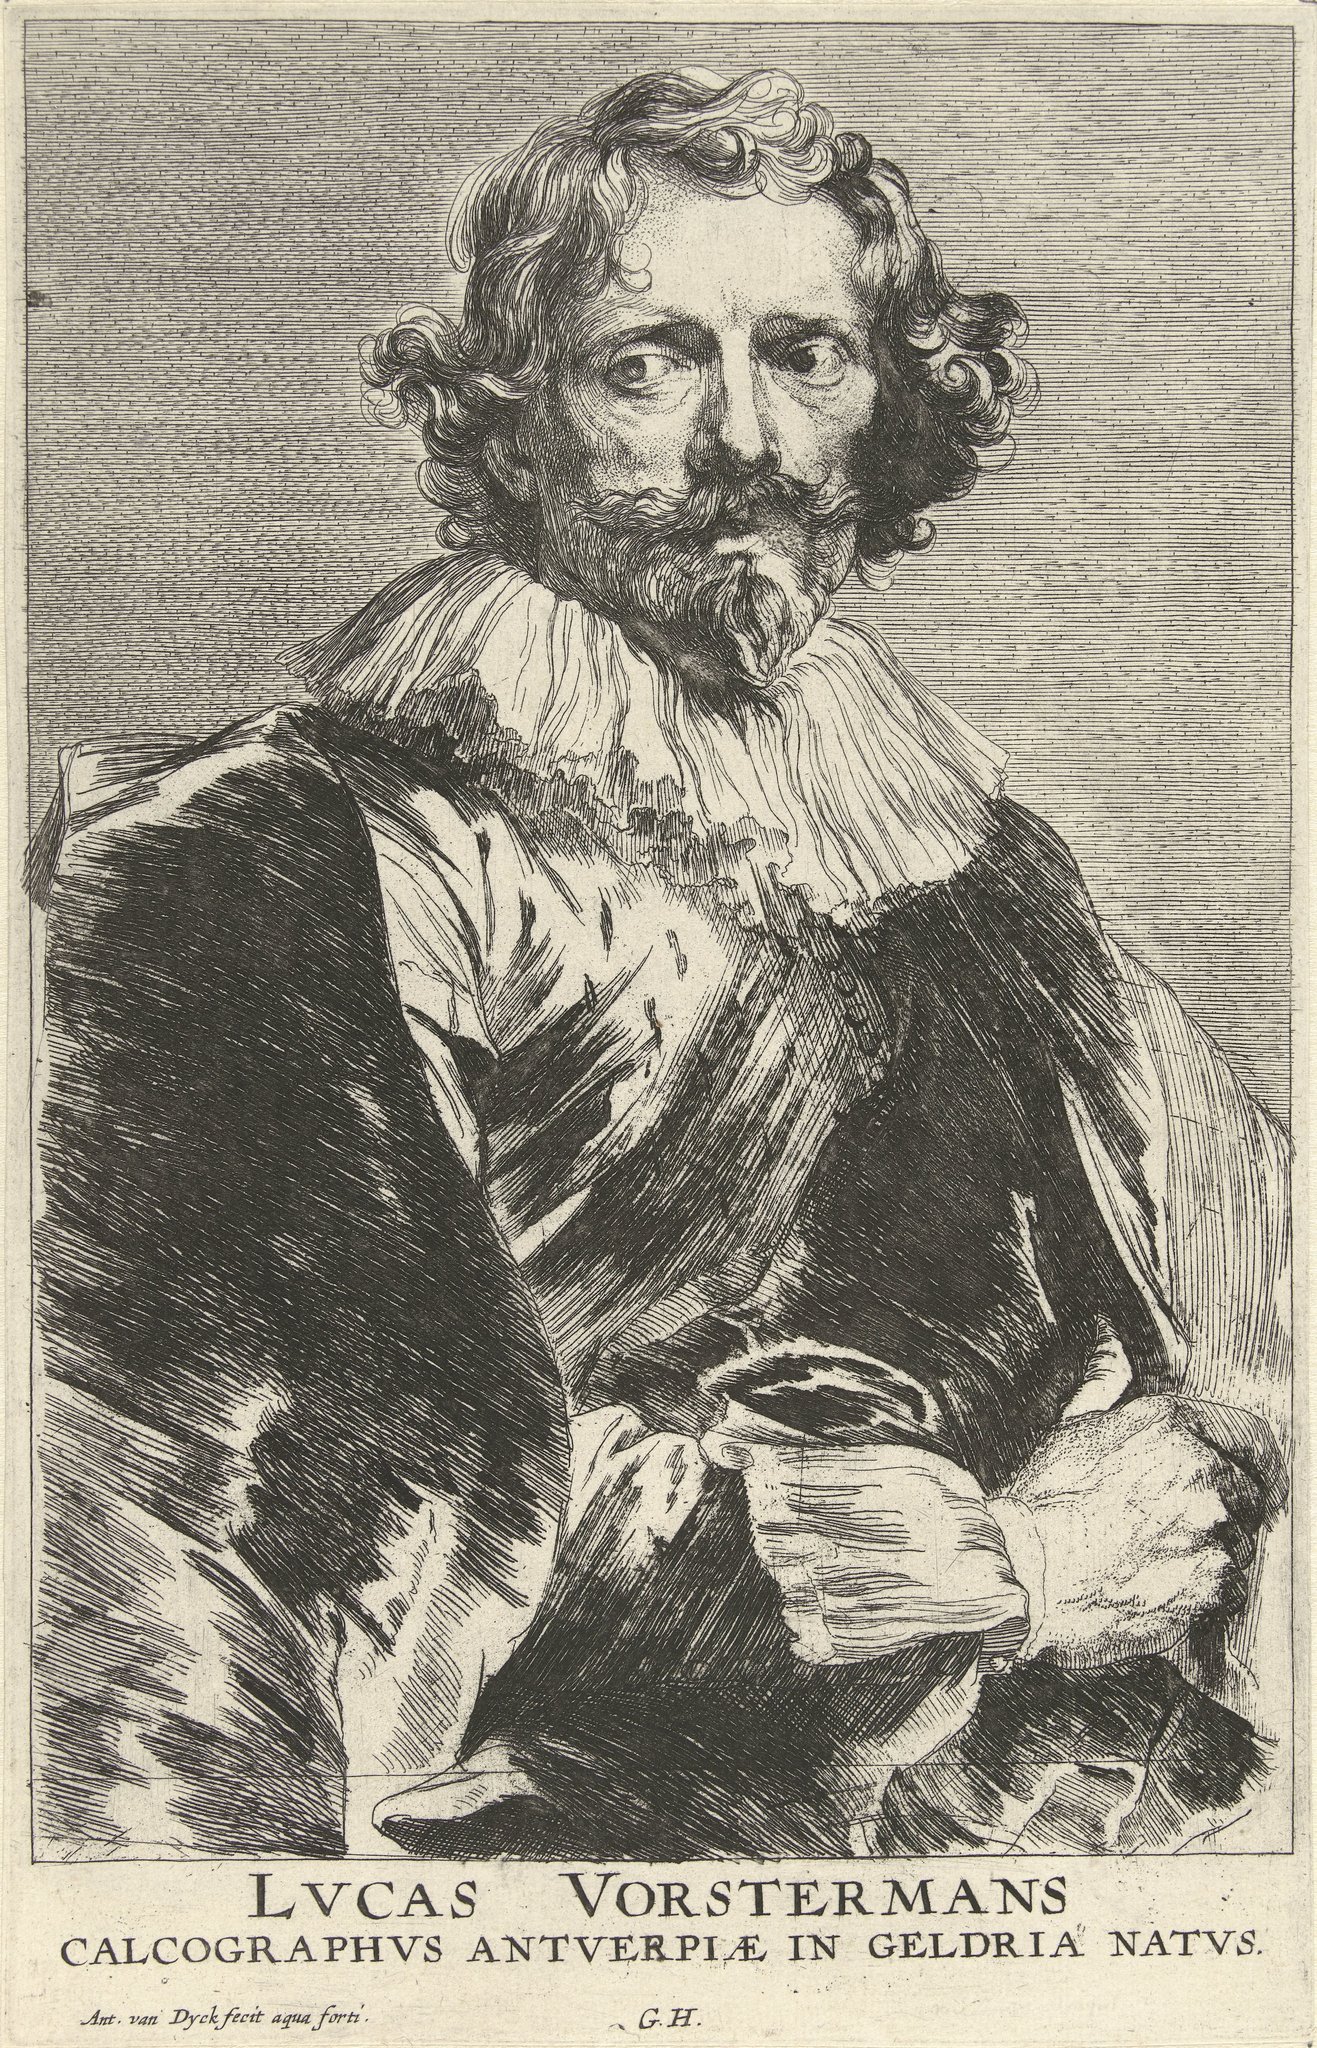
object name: print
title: Iconographie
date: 1630-1632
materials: paper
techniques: engraving, etching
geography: low countries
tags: lucas vorsterman, portrait, self-portrait of graphic artist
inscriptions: collector's mark: Lugt 240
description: Portret van Lucas Vorsterman I met onderschrift LVCAS VORSTERMANS CALCOGRAPHVS ANTVERPIAE IN GELDRIA NATVS